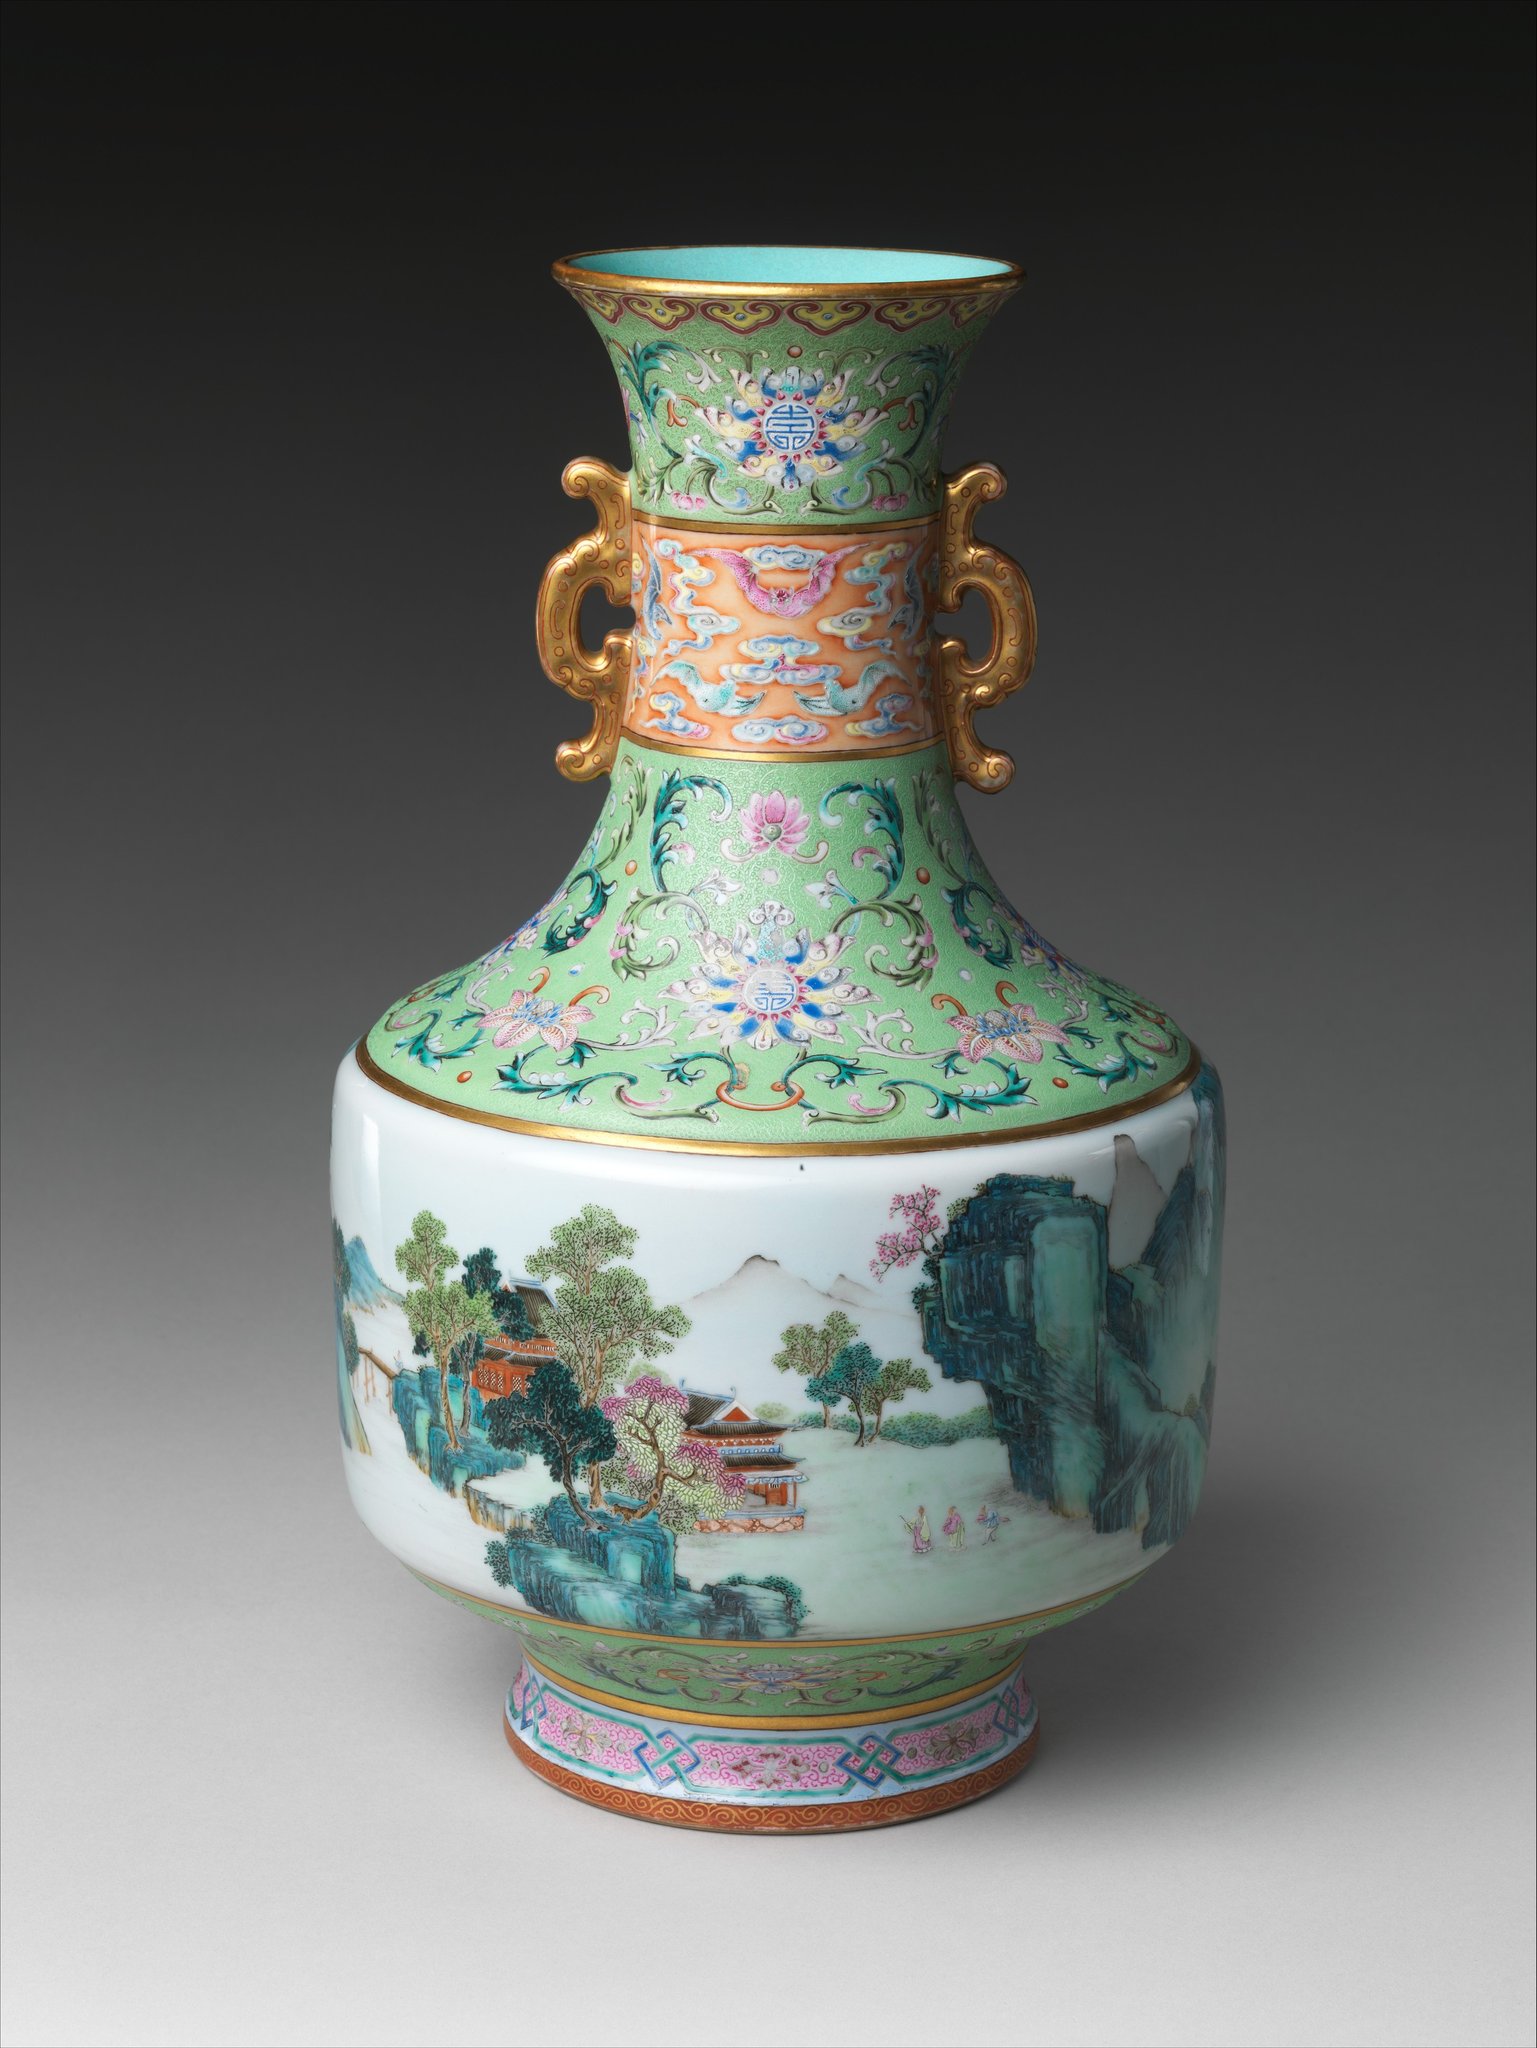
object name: vase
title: Vase with landscape decoration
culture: chinese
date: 1736-1795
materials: enamel, porcelain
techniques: incising, overglaze, painting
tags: flowers,landscapes,trees